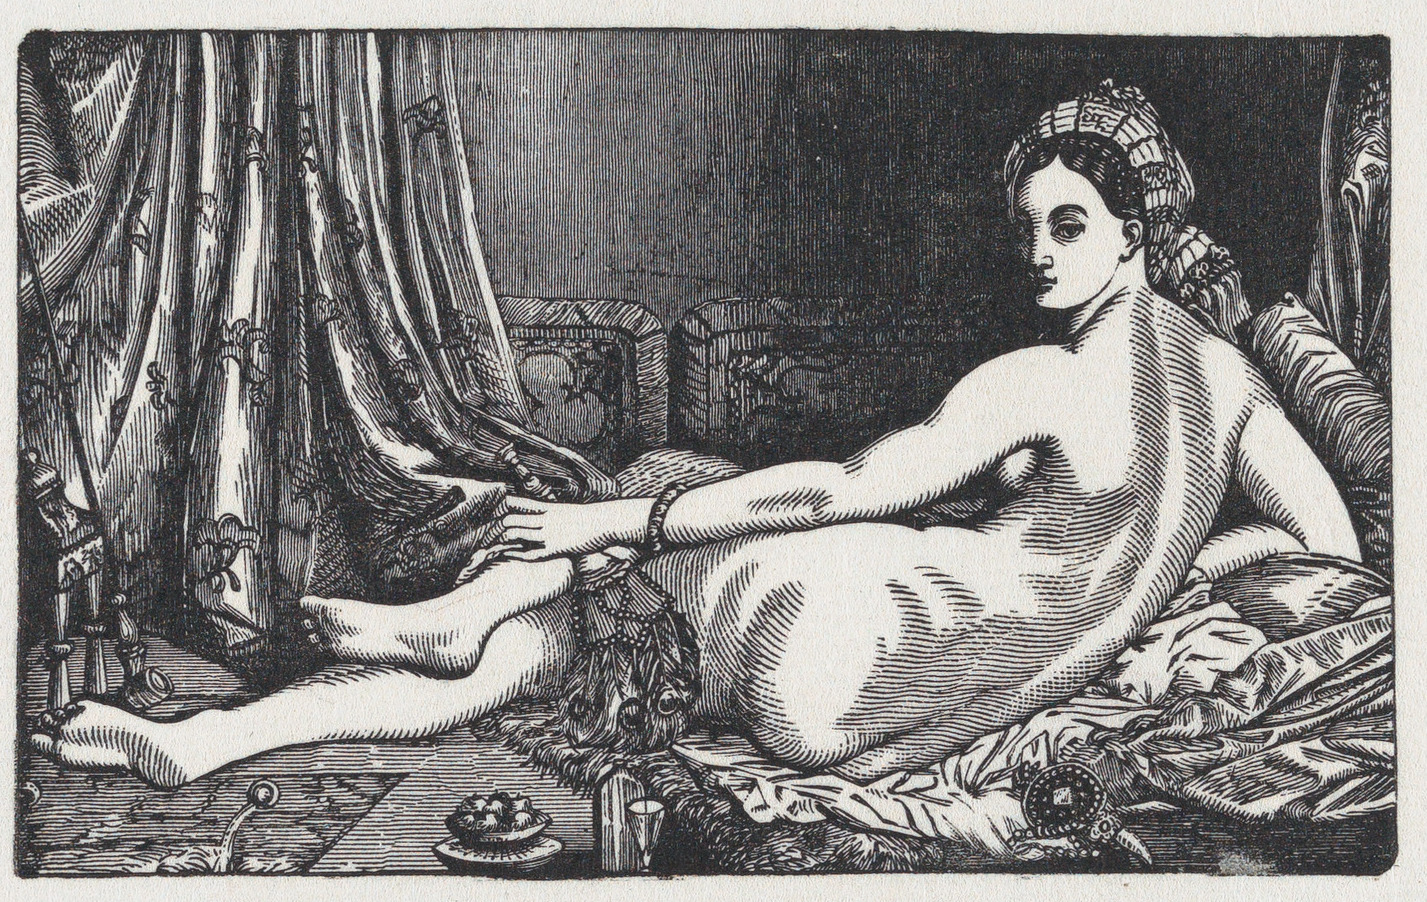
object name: print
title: Odalisque viewed from behind, after Ingres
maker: anonymous, mexican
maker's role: artist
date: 1801-1900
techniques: engraving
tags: female nudes